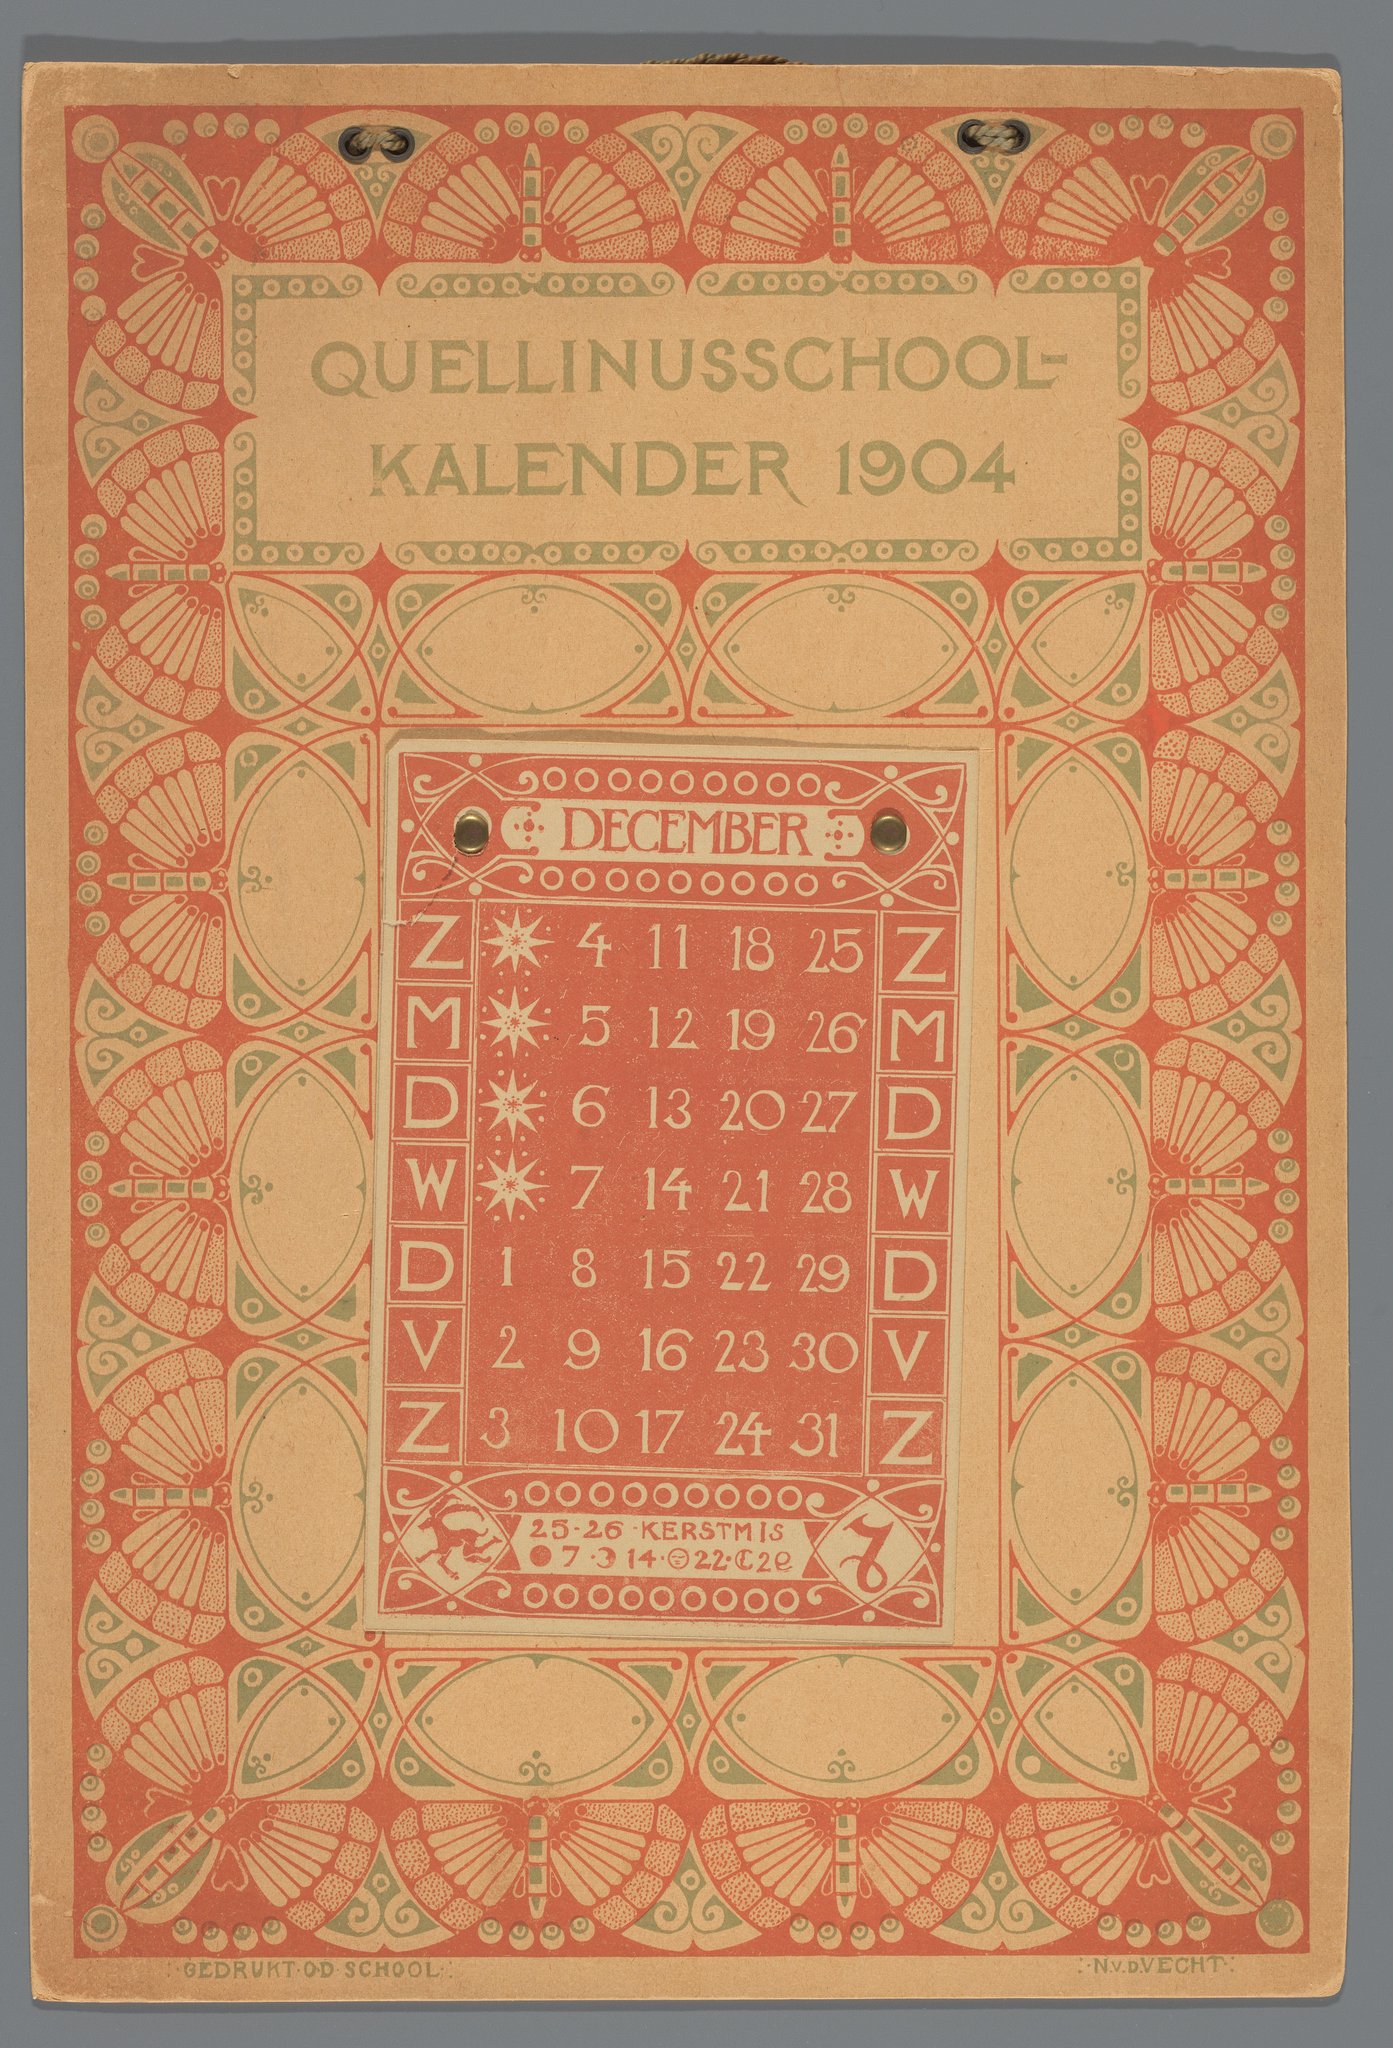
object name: calendar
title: Kalender van de Quellinusschool voor december 1904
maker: nicolaas van de vecht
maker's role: print maker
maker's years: 1886-1941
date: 1903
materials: cardboard, paper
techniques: lithograph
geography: amsterdam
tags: calendar, almanac, insects: butterfly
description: Kalenderschild met decoratie in de vorm van gestileerde vlinders. In het midden het kalenderblad voor december, met de dagen van de maanstanden en twee symbolen voor Steenbok in de ondermarge.